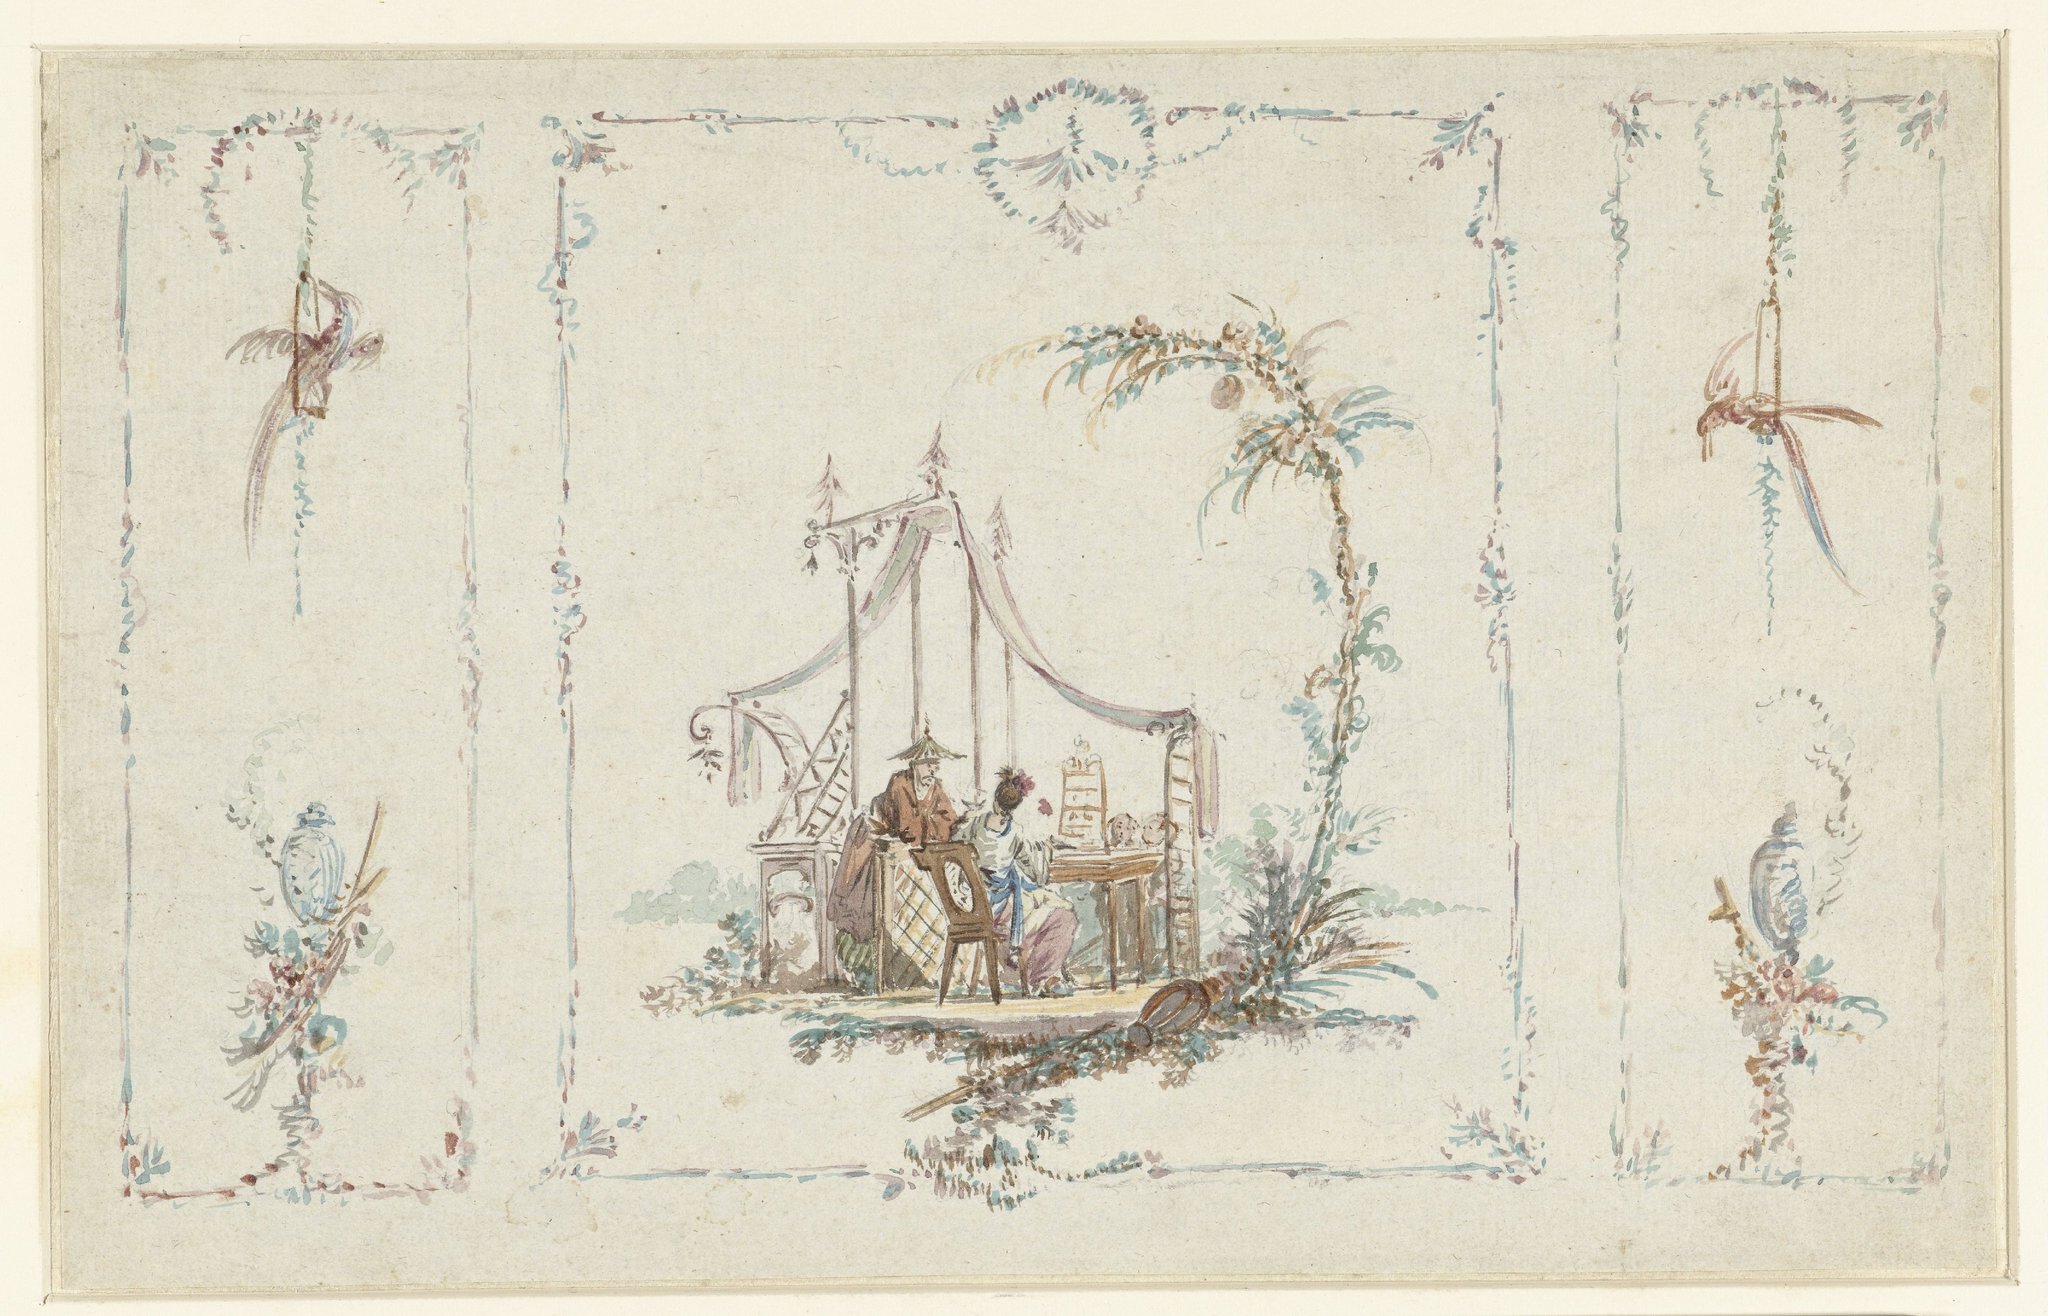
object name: ornamenttekening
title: Design sketch in Chinoiserie style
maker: abraham van strij (i)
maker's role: draughtsman, painter, print maker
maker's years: 1753-1826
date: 1763-1826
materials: paper, watercolor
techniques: brush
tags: chinese, ornaments ~ art (+ rococo ~ ornament style)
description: Een vrouw zittend aan een tafeltje, daarbij een man en twee kinderen.